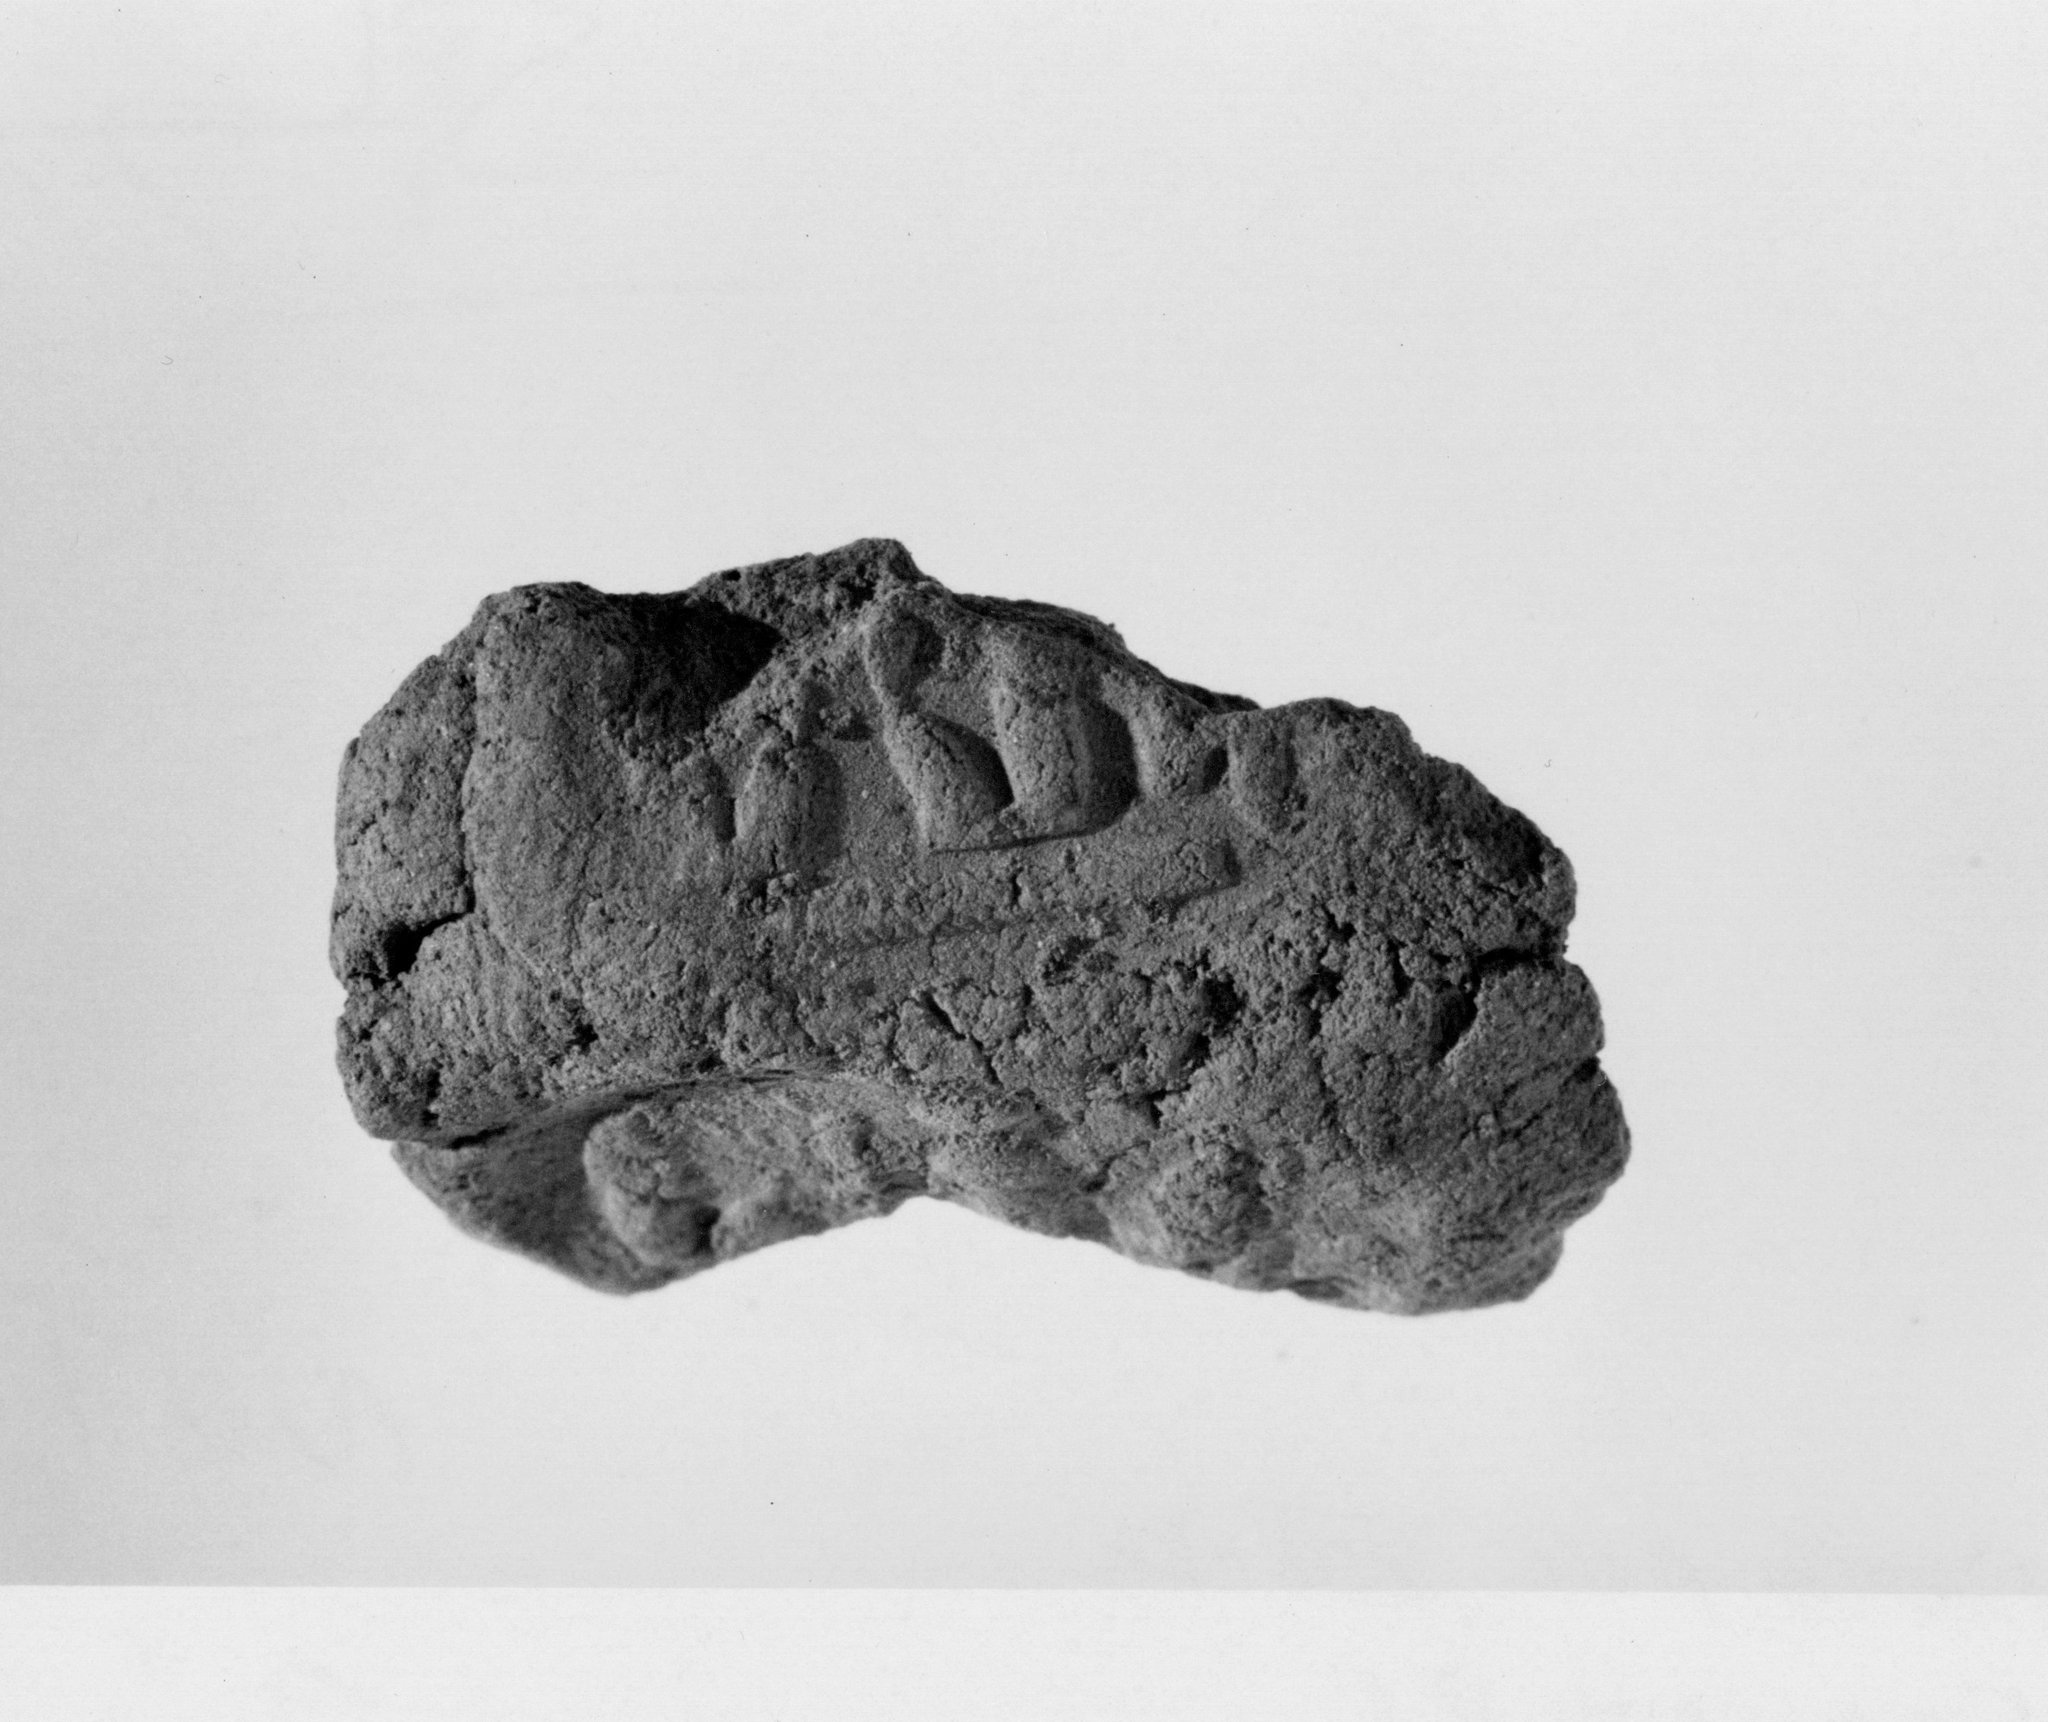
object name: sealing, nebmaatre, amenhotep iii, thoth, double crown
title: Document Sealing With the Throne Name of Amenhotep III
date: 1390-1352 BCE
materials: mud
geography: egypt